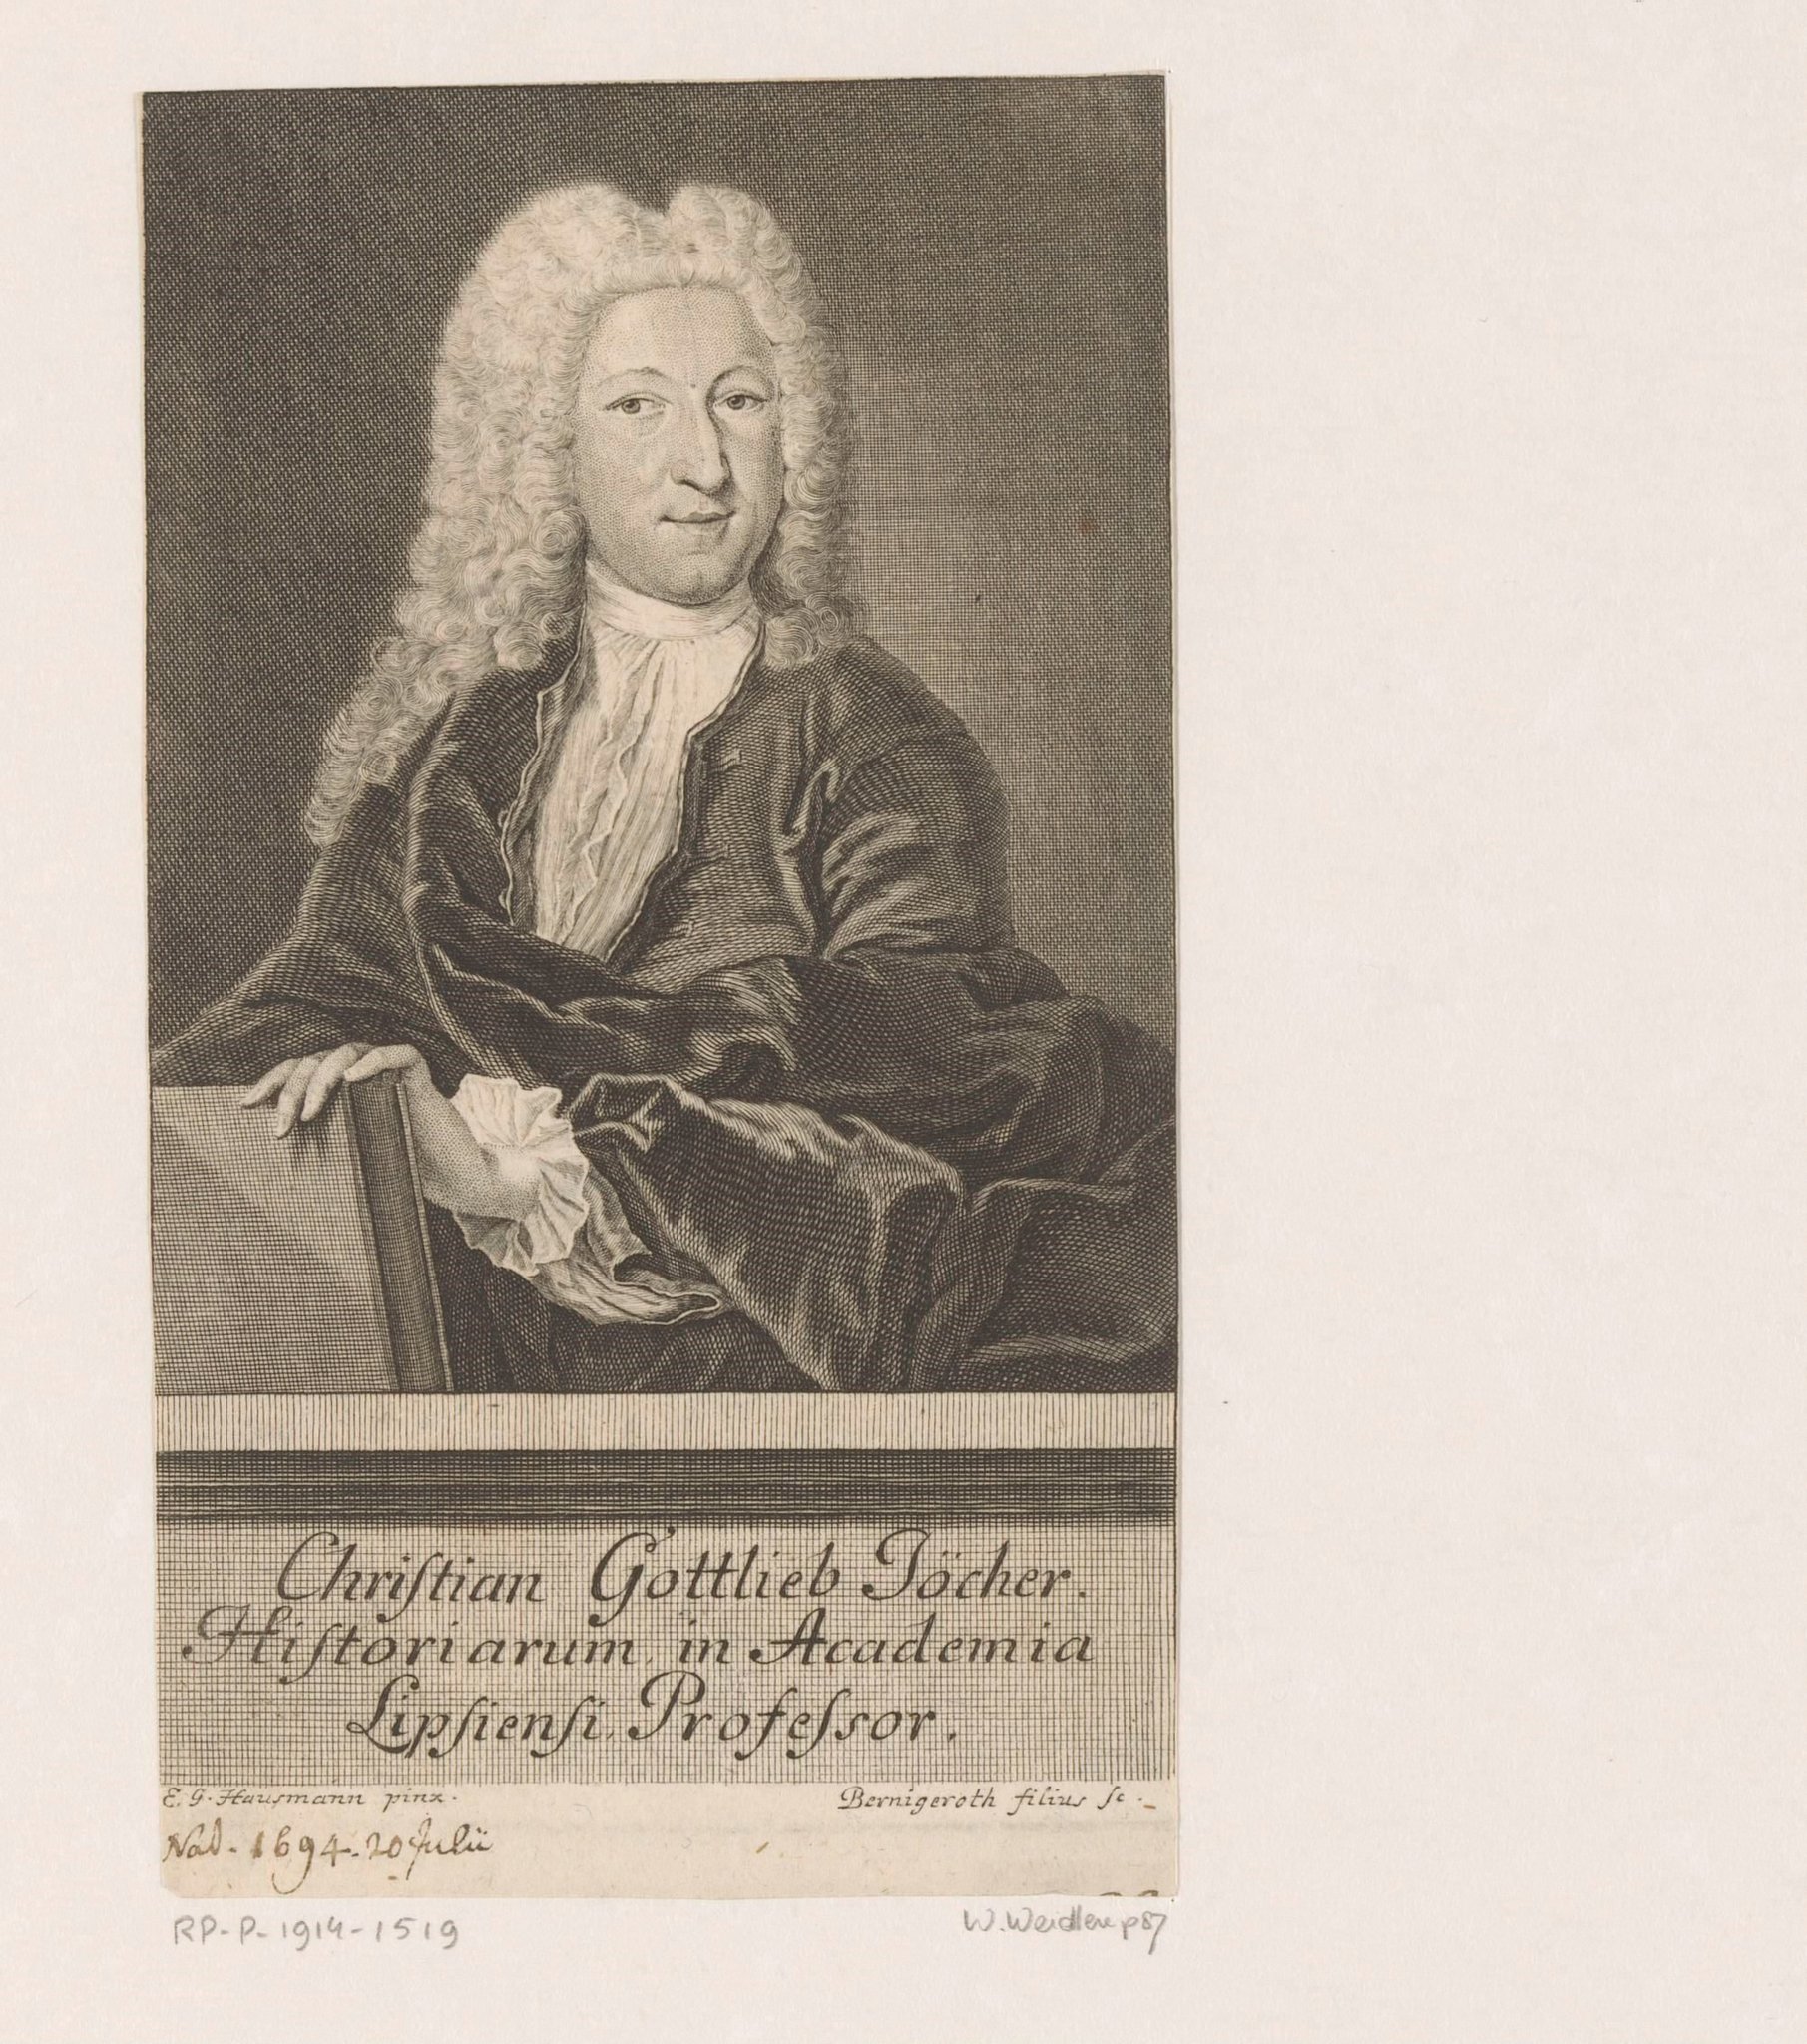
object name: print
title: Portret van Christian Gottlieb Jöcher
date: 1733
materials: paper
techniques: engraving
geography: leipzig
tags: historical persons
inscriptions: collector's mark: Lugt 2228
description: Prent ook gebruikt in: Deutsche Acta Eruditorum (...). dl. 177. Leipzig: Johann Gottlieb Gleditsch, 1733.